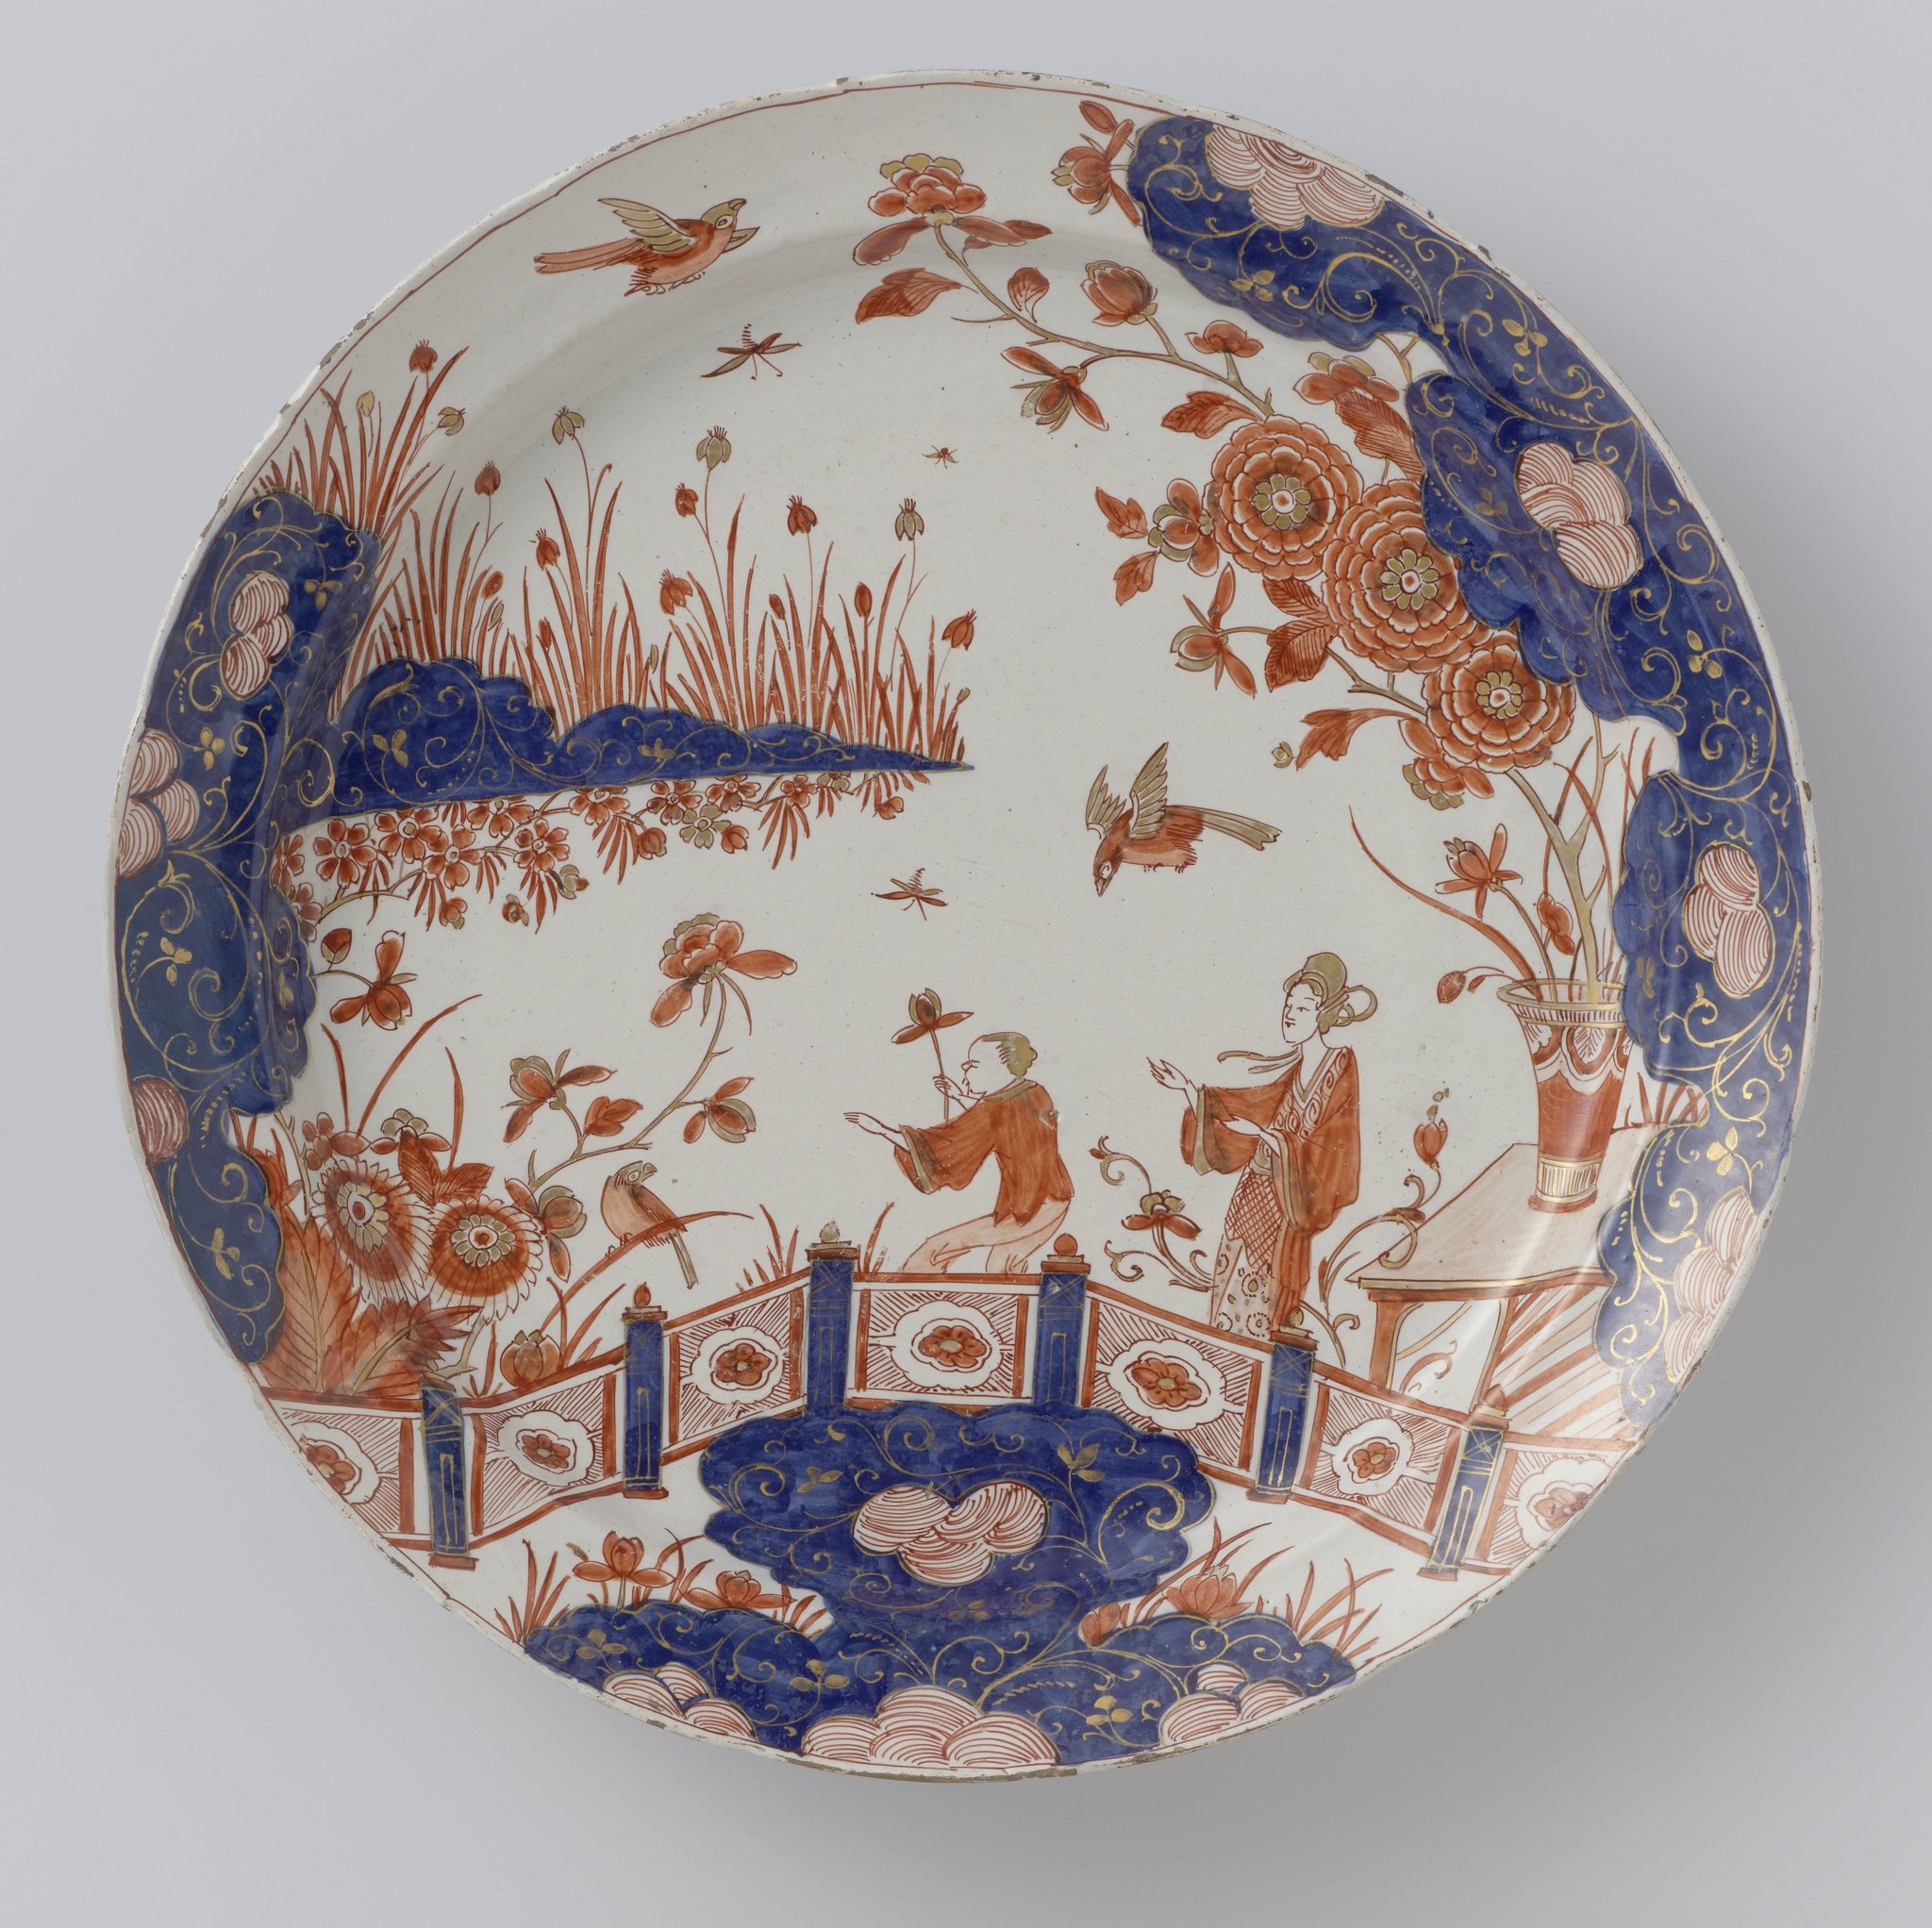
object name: platter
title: Dish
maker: Anonymous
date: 1700-1715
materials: earthenware, glaze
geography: delft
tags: chinese (+ other cultural aspects)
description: Schotel van faïence. Veelkleurig beschilderd.